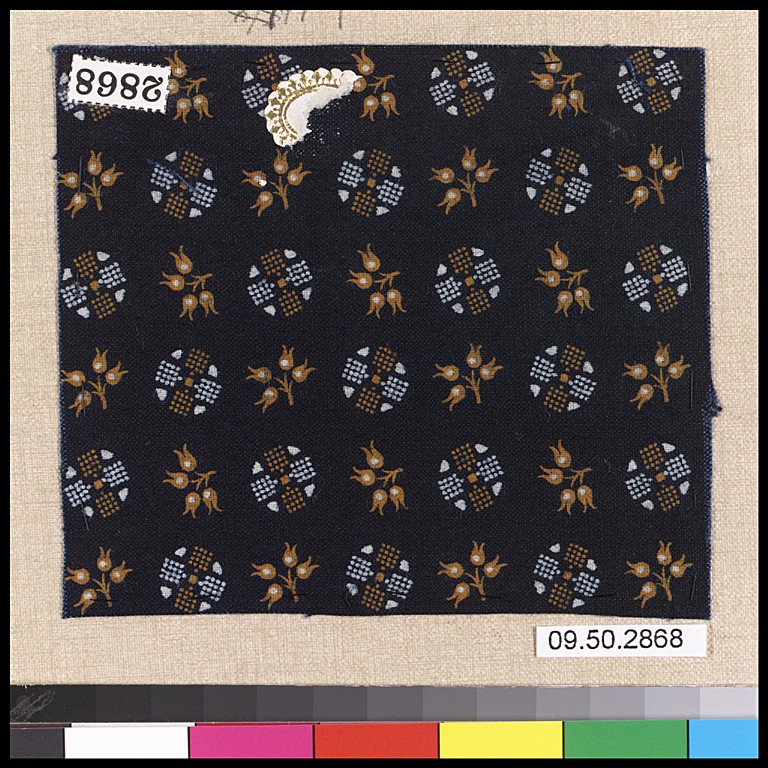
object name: piece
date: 1801-1900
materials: cotton